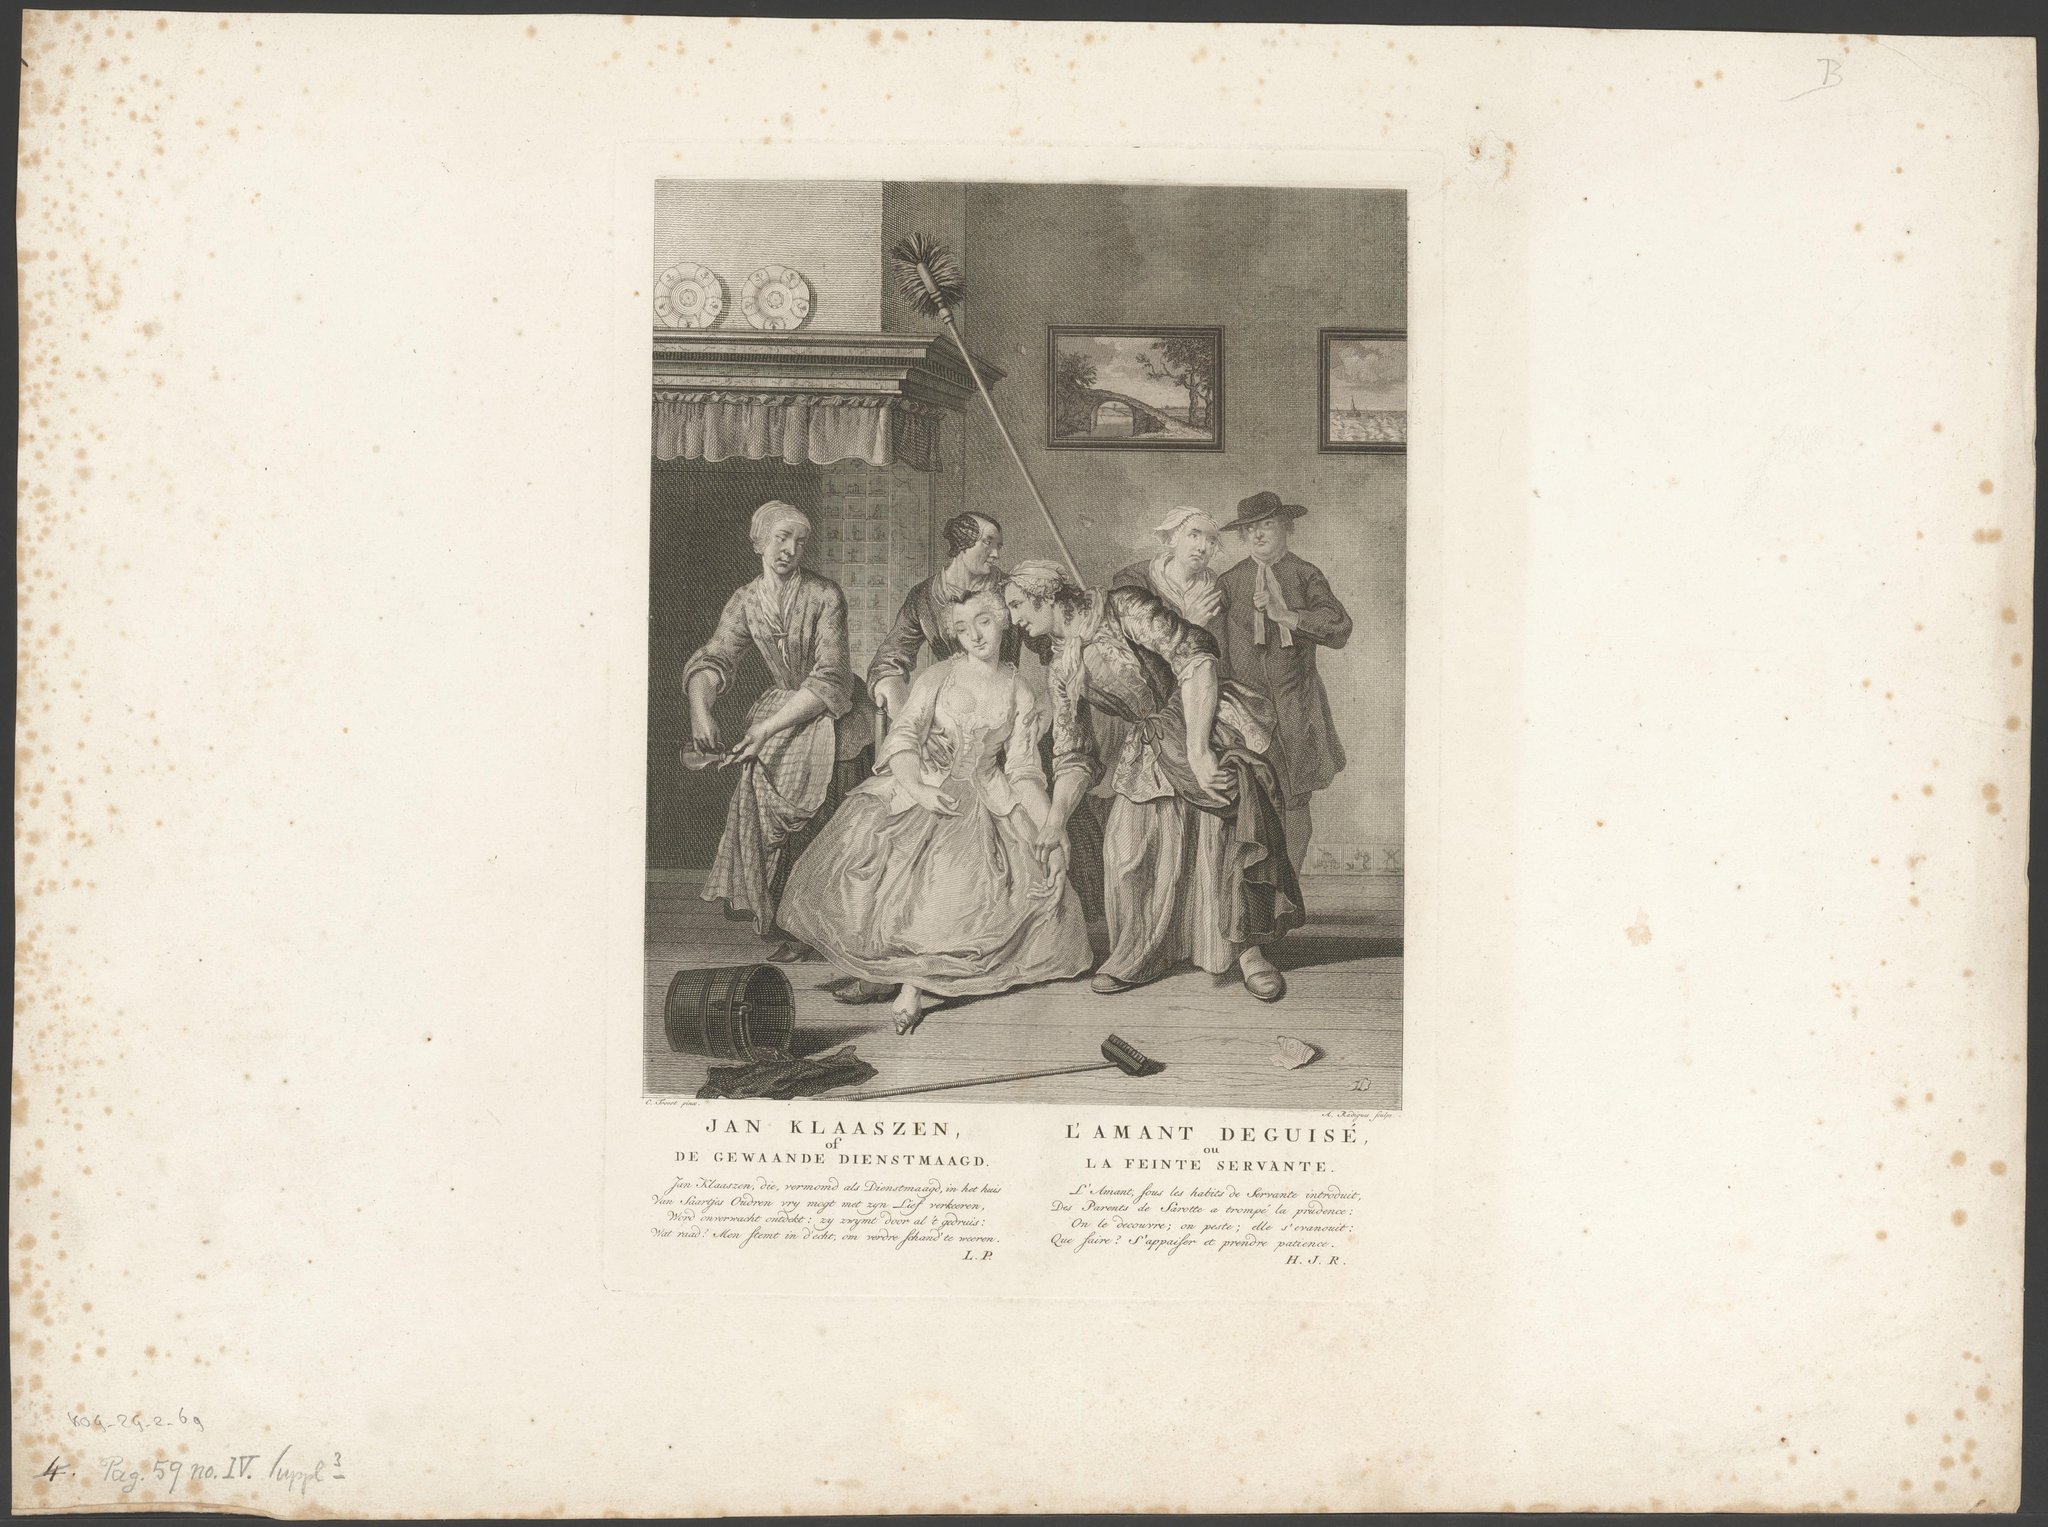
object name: print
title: Jan Klaaszen, of de gewaande Dienstmaagd / L'Amant deguisé, ou La Feinte Servante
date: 1757-1764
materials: paper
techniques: engraving, etching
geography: amsterdam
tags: man dressed as woman, travesty, maid ~ house personnel, comedy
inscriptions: collector's mark: Lugt 2488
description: Saartje valt in zwijm als ontdekt wordt dat haar geliefde Jan Klaaszen zich vermomd had als dienstmeid, om zo bij haar te kunnen zijn. Onderaan in de marge twee vierregelige verzen in het Nederlands en het Frans.